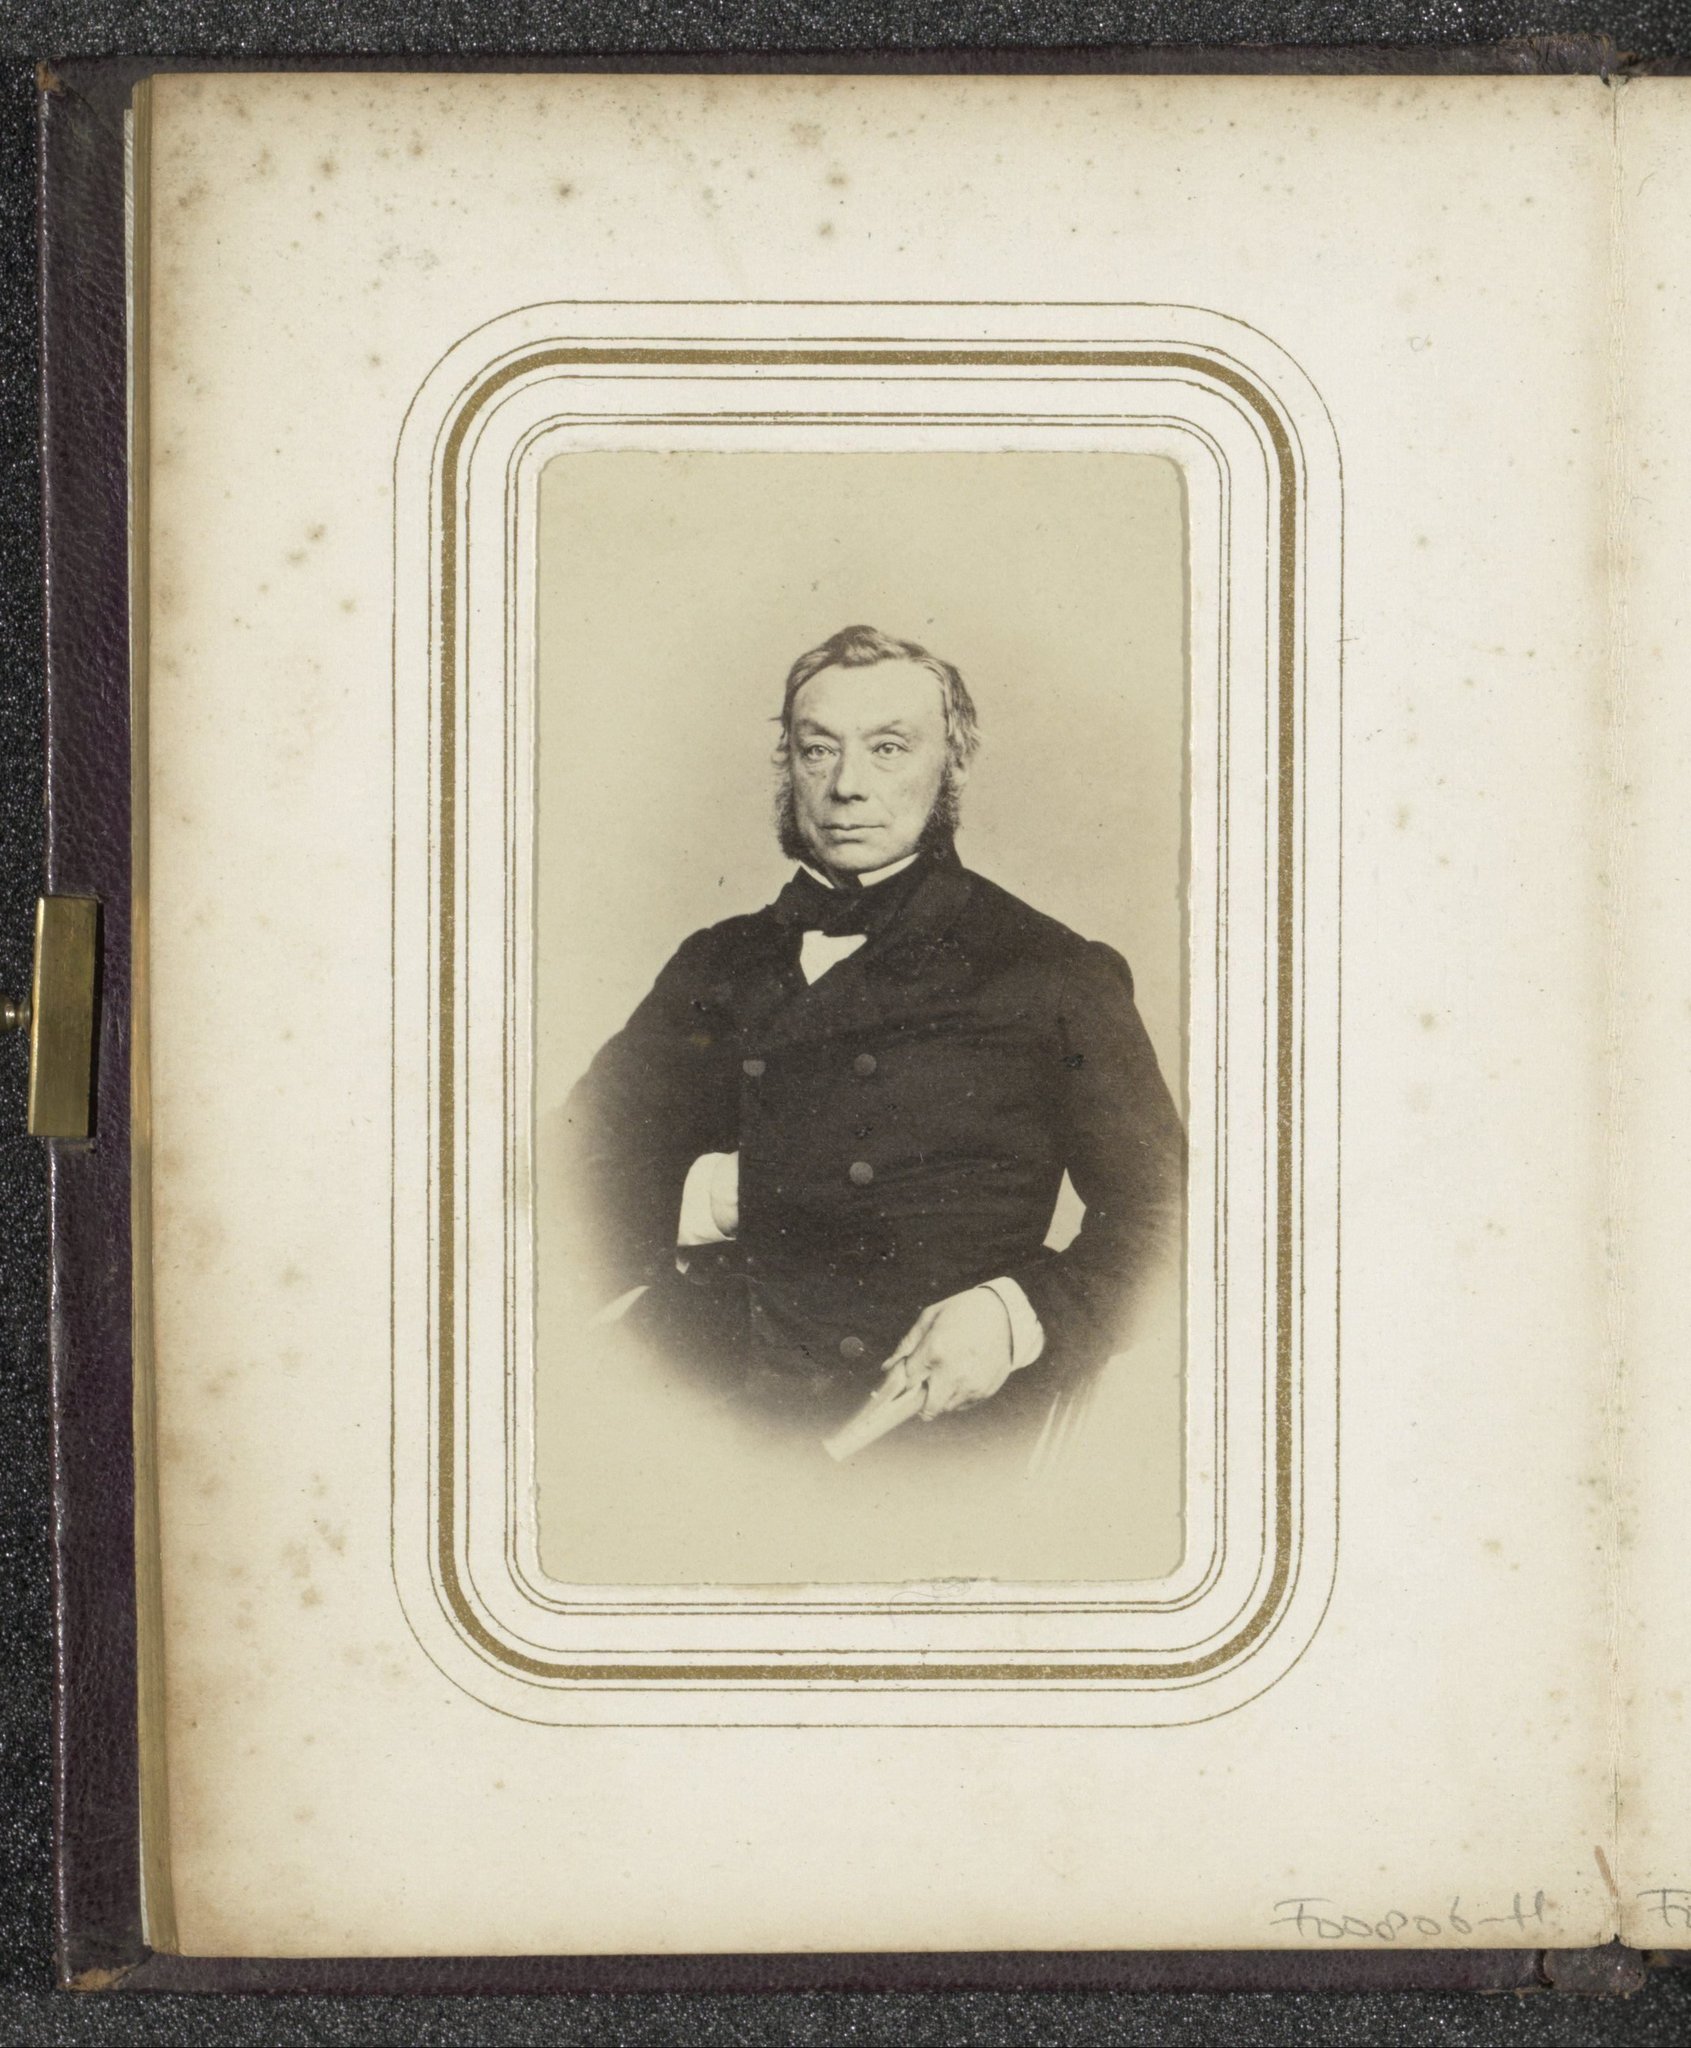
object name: carte de visite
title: Portret van een man met bakkebaarden en een hand in zijn jas gestoken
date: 1862-1869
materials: cardboard, paper, photographic support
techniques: albumen print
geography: haarlem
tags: hand not visible, sideburns, historical persons, neck-gear ~ clothing, book, coat, cape, haarlem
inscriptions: address: ‘Zijlstraat No. 759 Haarlem.’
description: Onderdeel van Fotoalbum met 36 cartes-de-visite van Nederlandse personen.